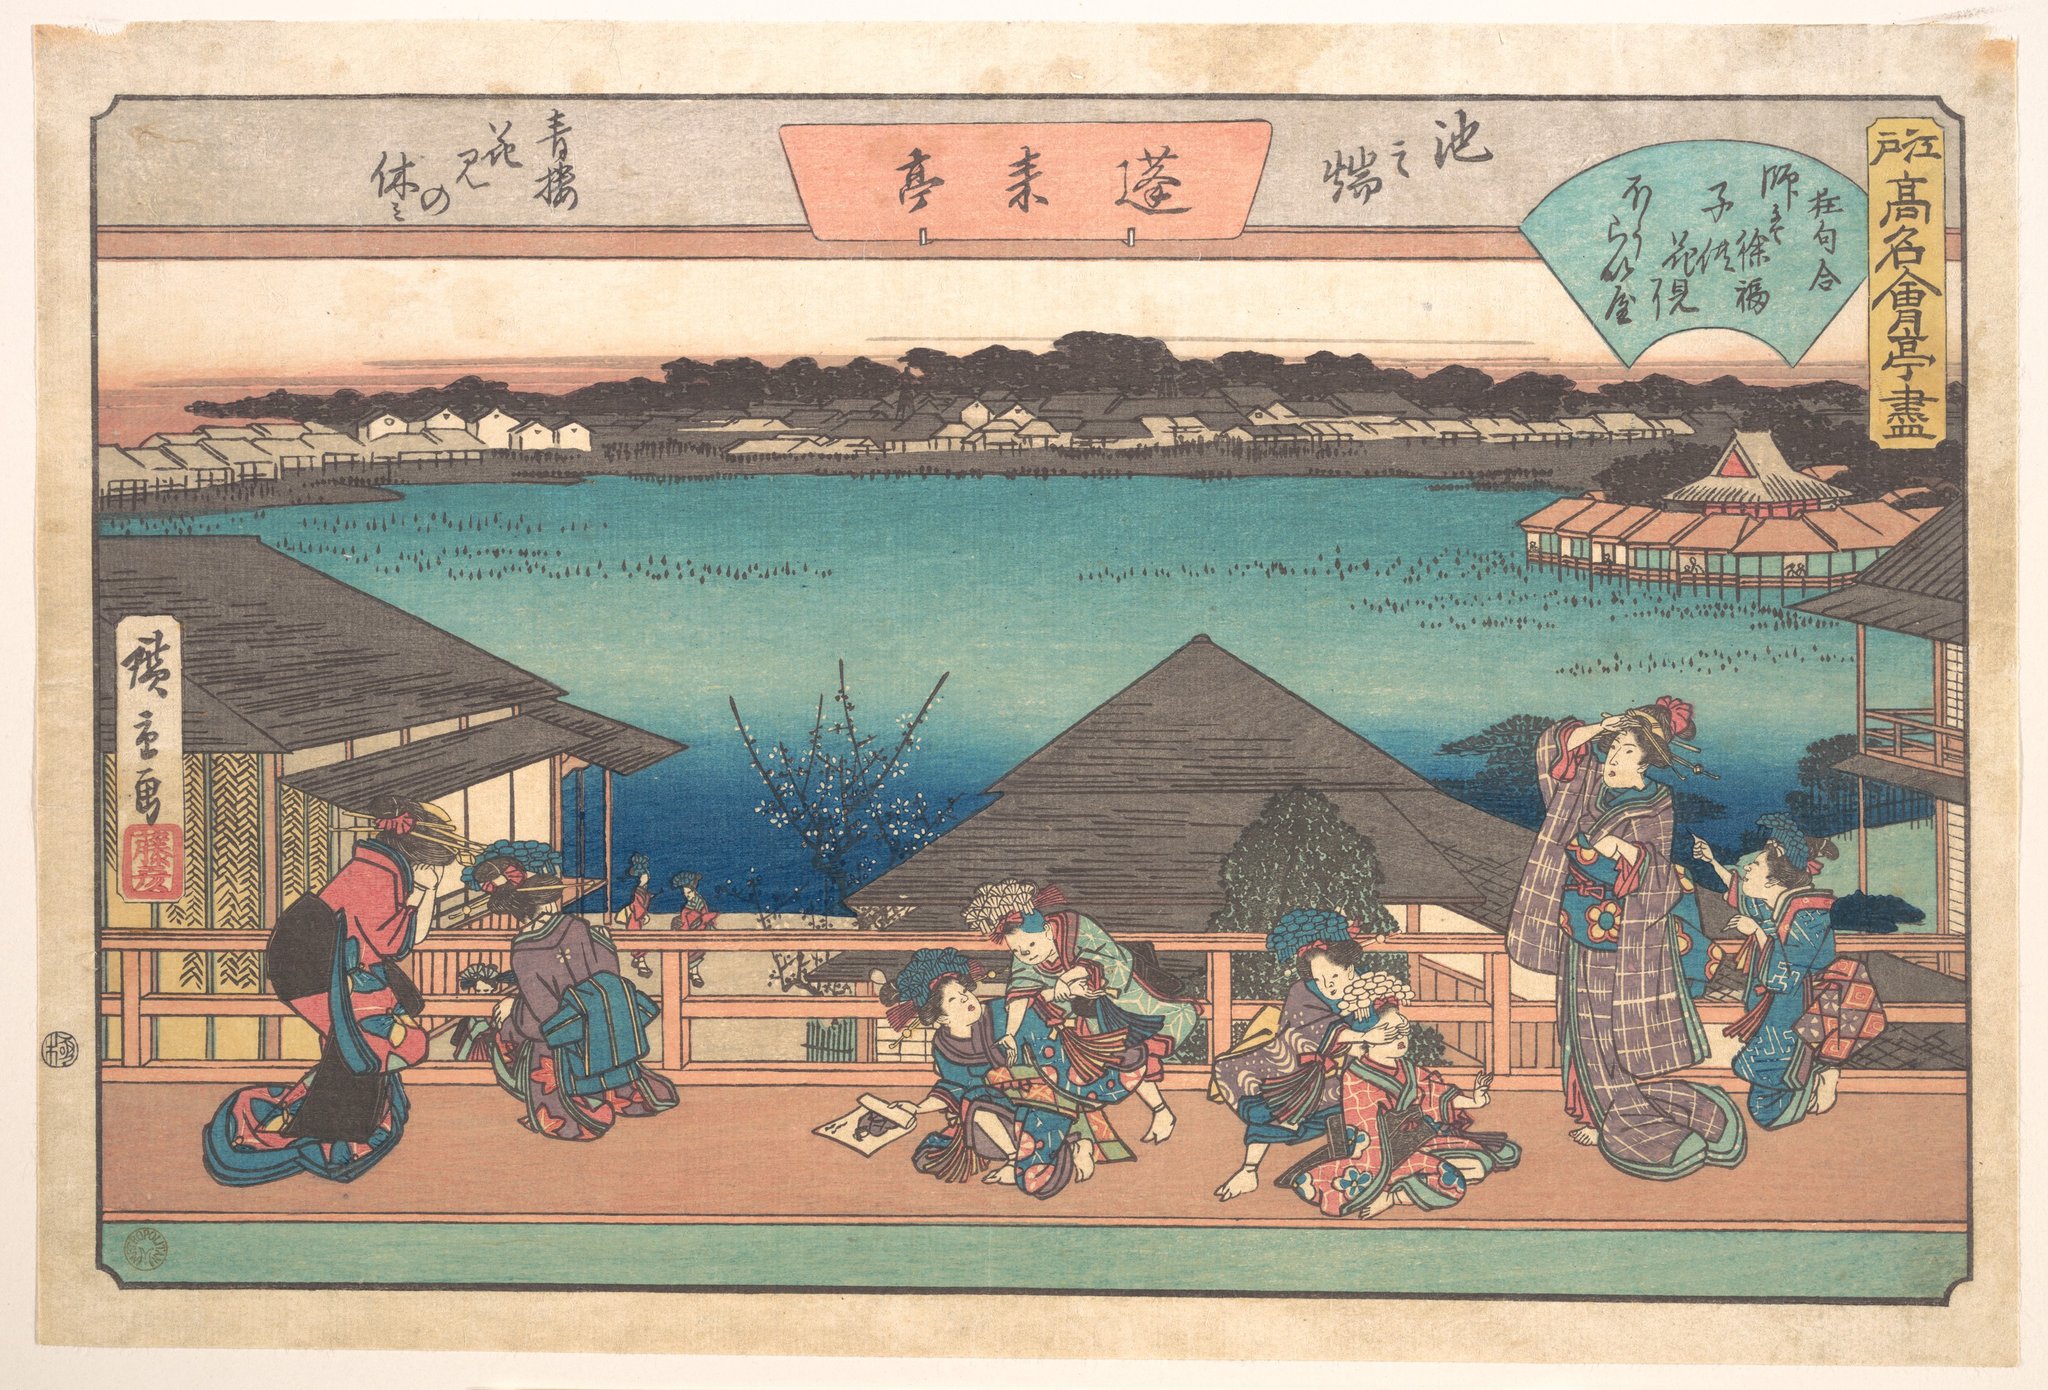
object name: print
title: Ikeno Mata (Horai-ya)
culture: japanese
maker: utagawa hiroshige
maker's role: artist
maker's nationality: japanese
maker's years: 1797-1858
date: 1840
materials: ink, paper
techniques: woodblock print